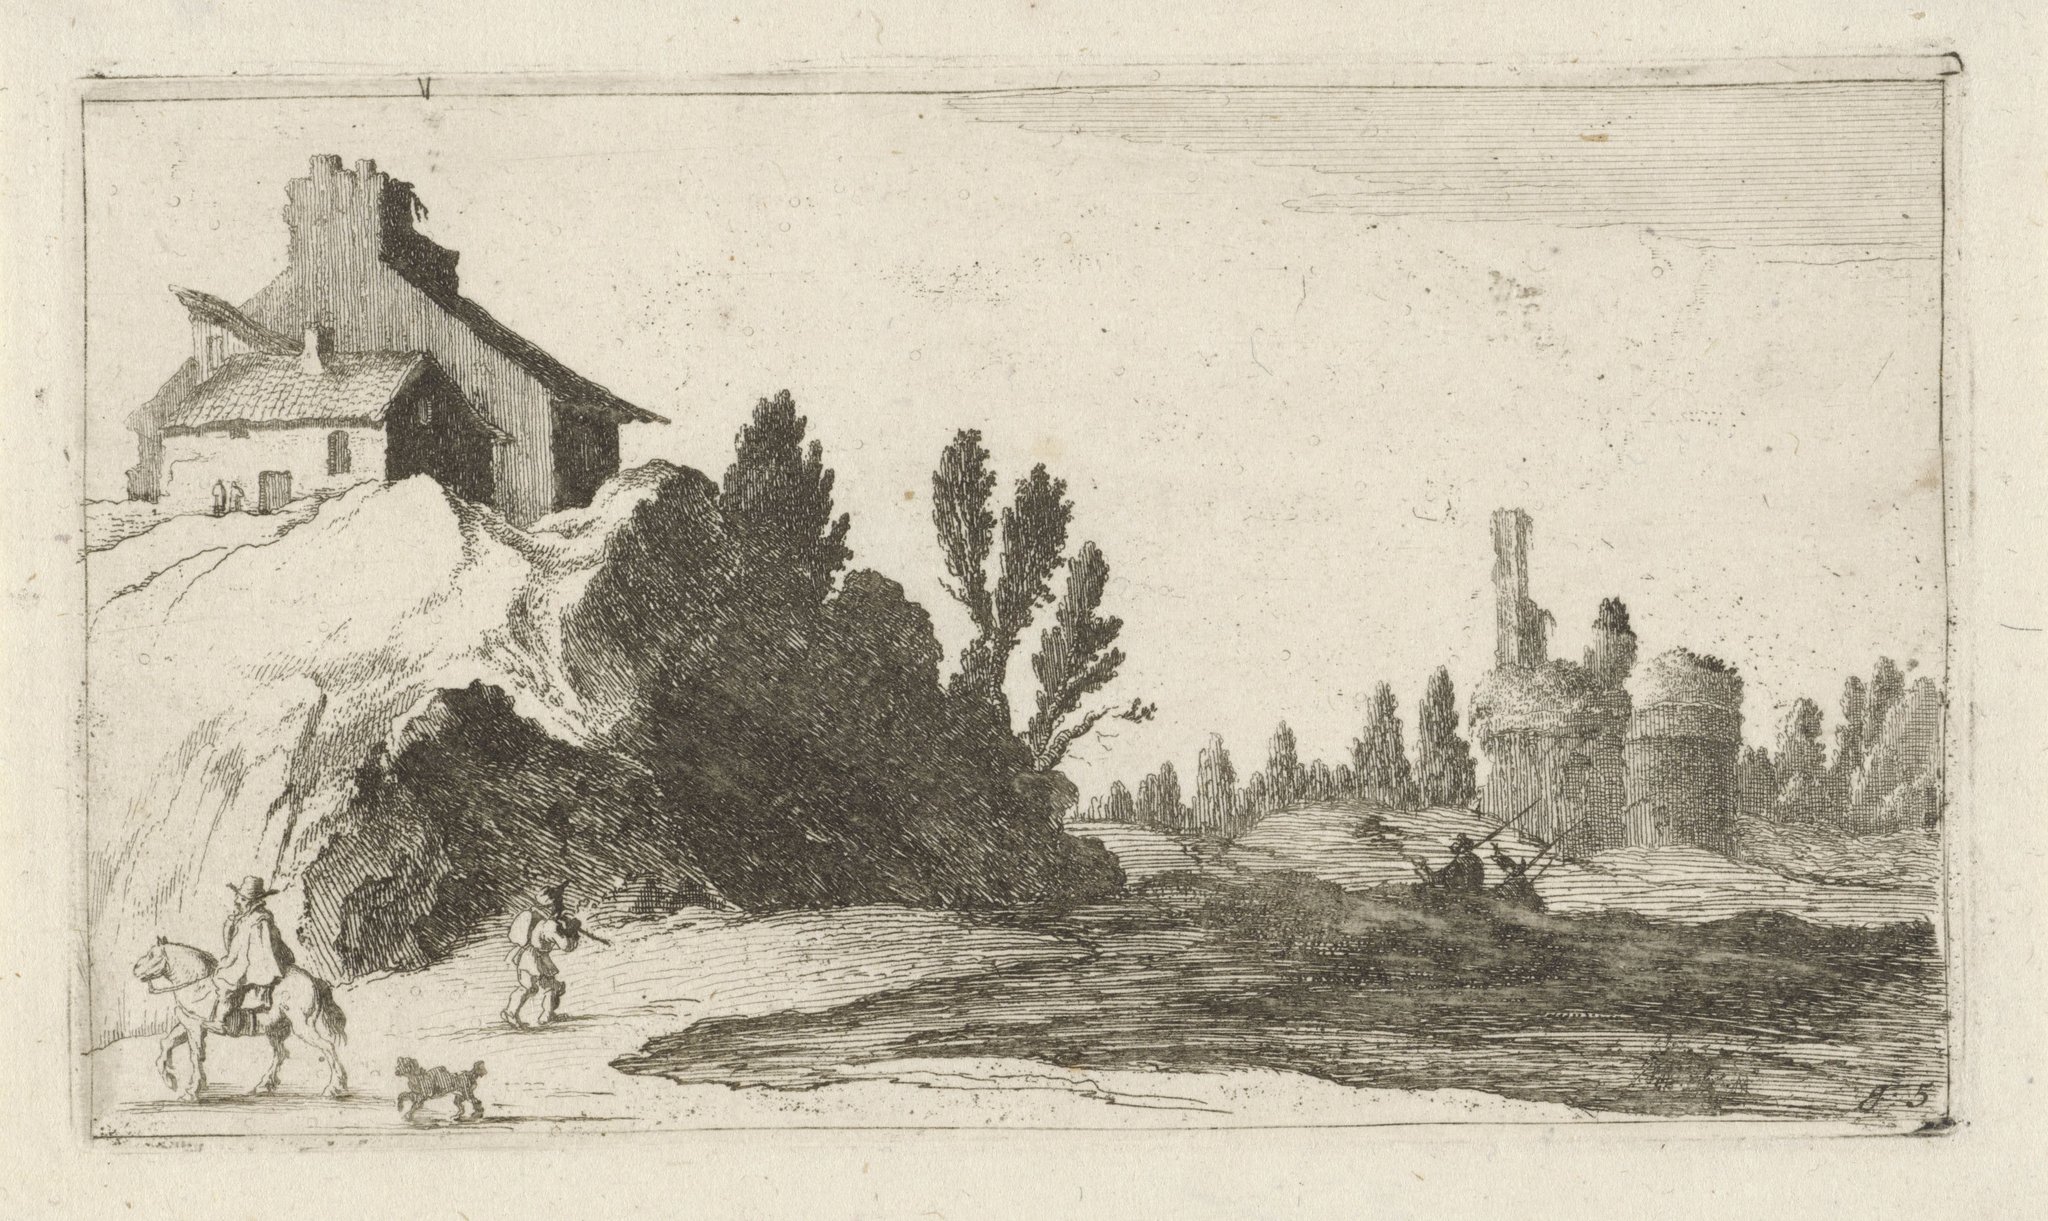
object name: print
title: Twaalf landschappen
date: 1640-1706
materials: paper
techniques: etching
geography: amsterdam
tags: riding a horse, ass, or mule; rider, horseman, landscape with ruins, farm or solitary house in landscape, fisherman, dog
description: Op een heuvel ligt een boerderij waar een landweg langs loopt. Op de weg een ruiter, een wandelaar en een hond. Op de achtergrond twee vissers en een ruïne. De prent maakt deel uit van een serie van twaalf landschappen.